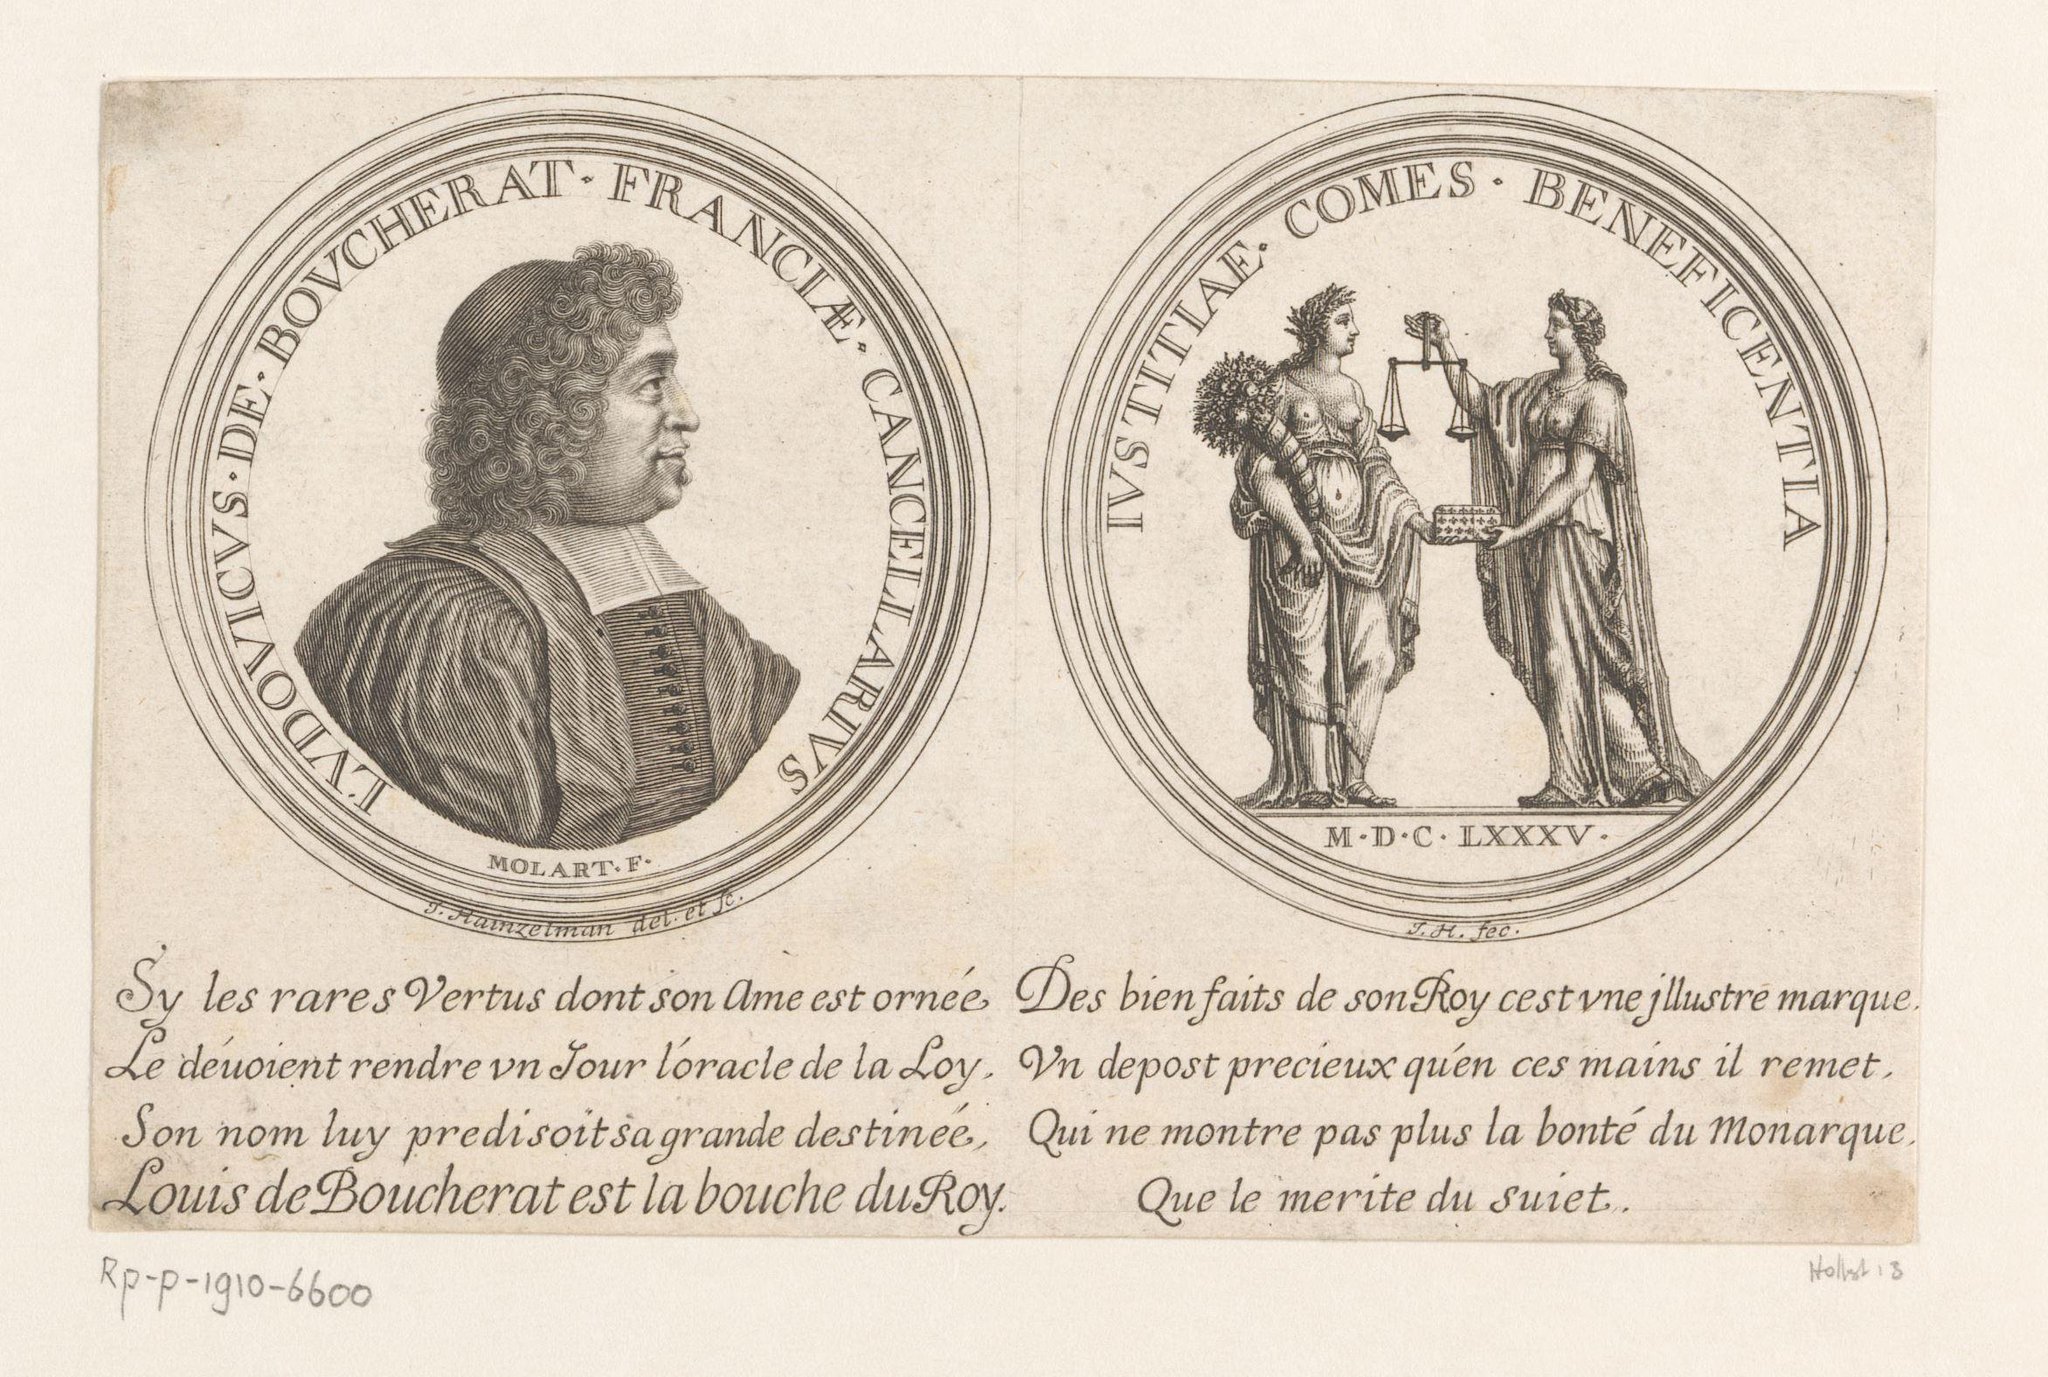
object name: print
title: Twee medailles met links het portret van Louis Boucherat en rechts de personificaties van weldaad en gerechtigheid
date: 1651-1693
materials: paper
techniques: engraving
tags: louis boucherat, benevolence, beneficence; 'beneficio', 'benevolenza o affettione' (ripa), historical persons, memorial medal, justitia (justice) as roman personification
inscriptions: collector's mark: Lugt 2228